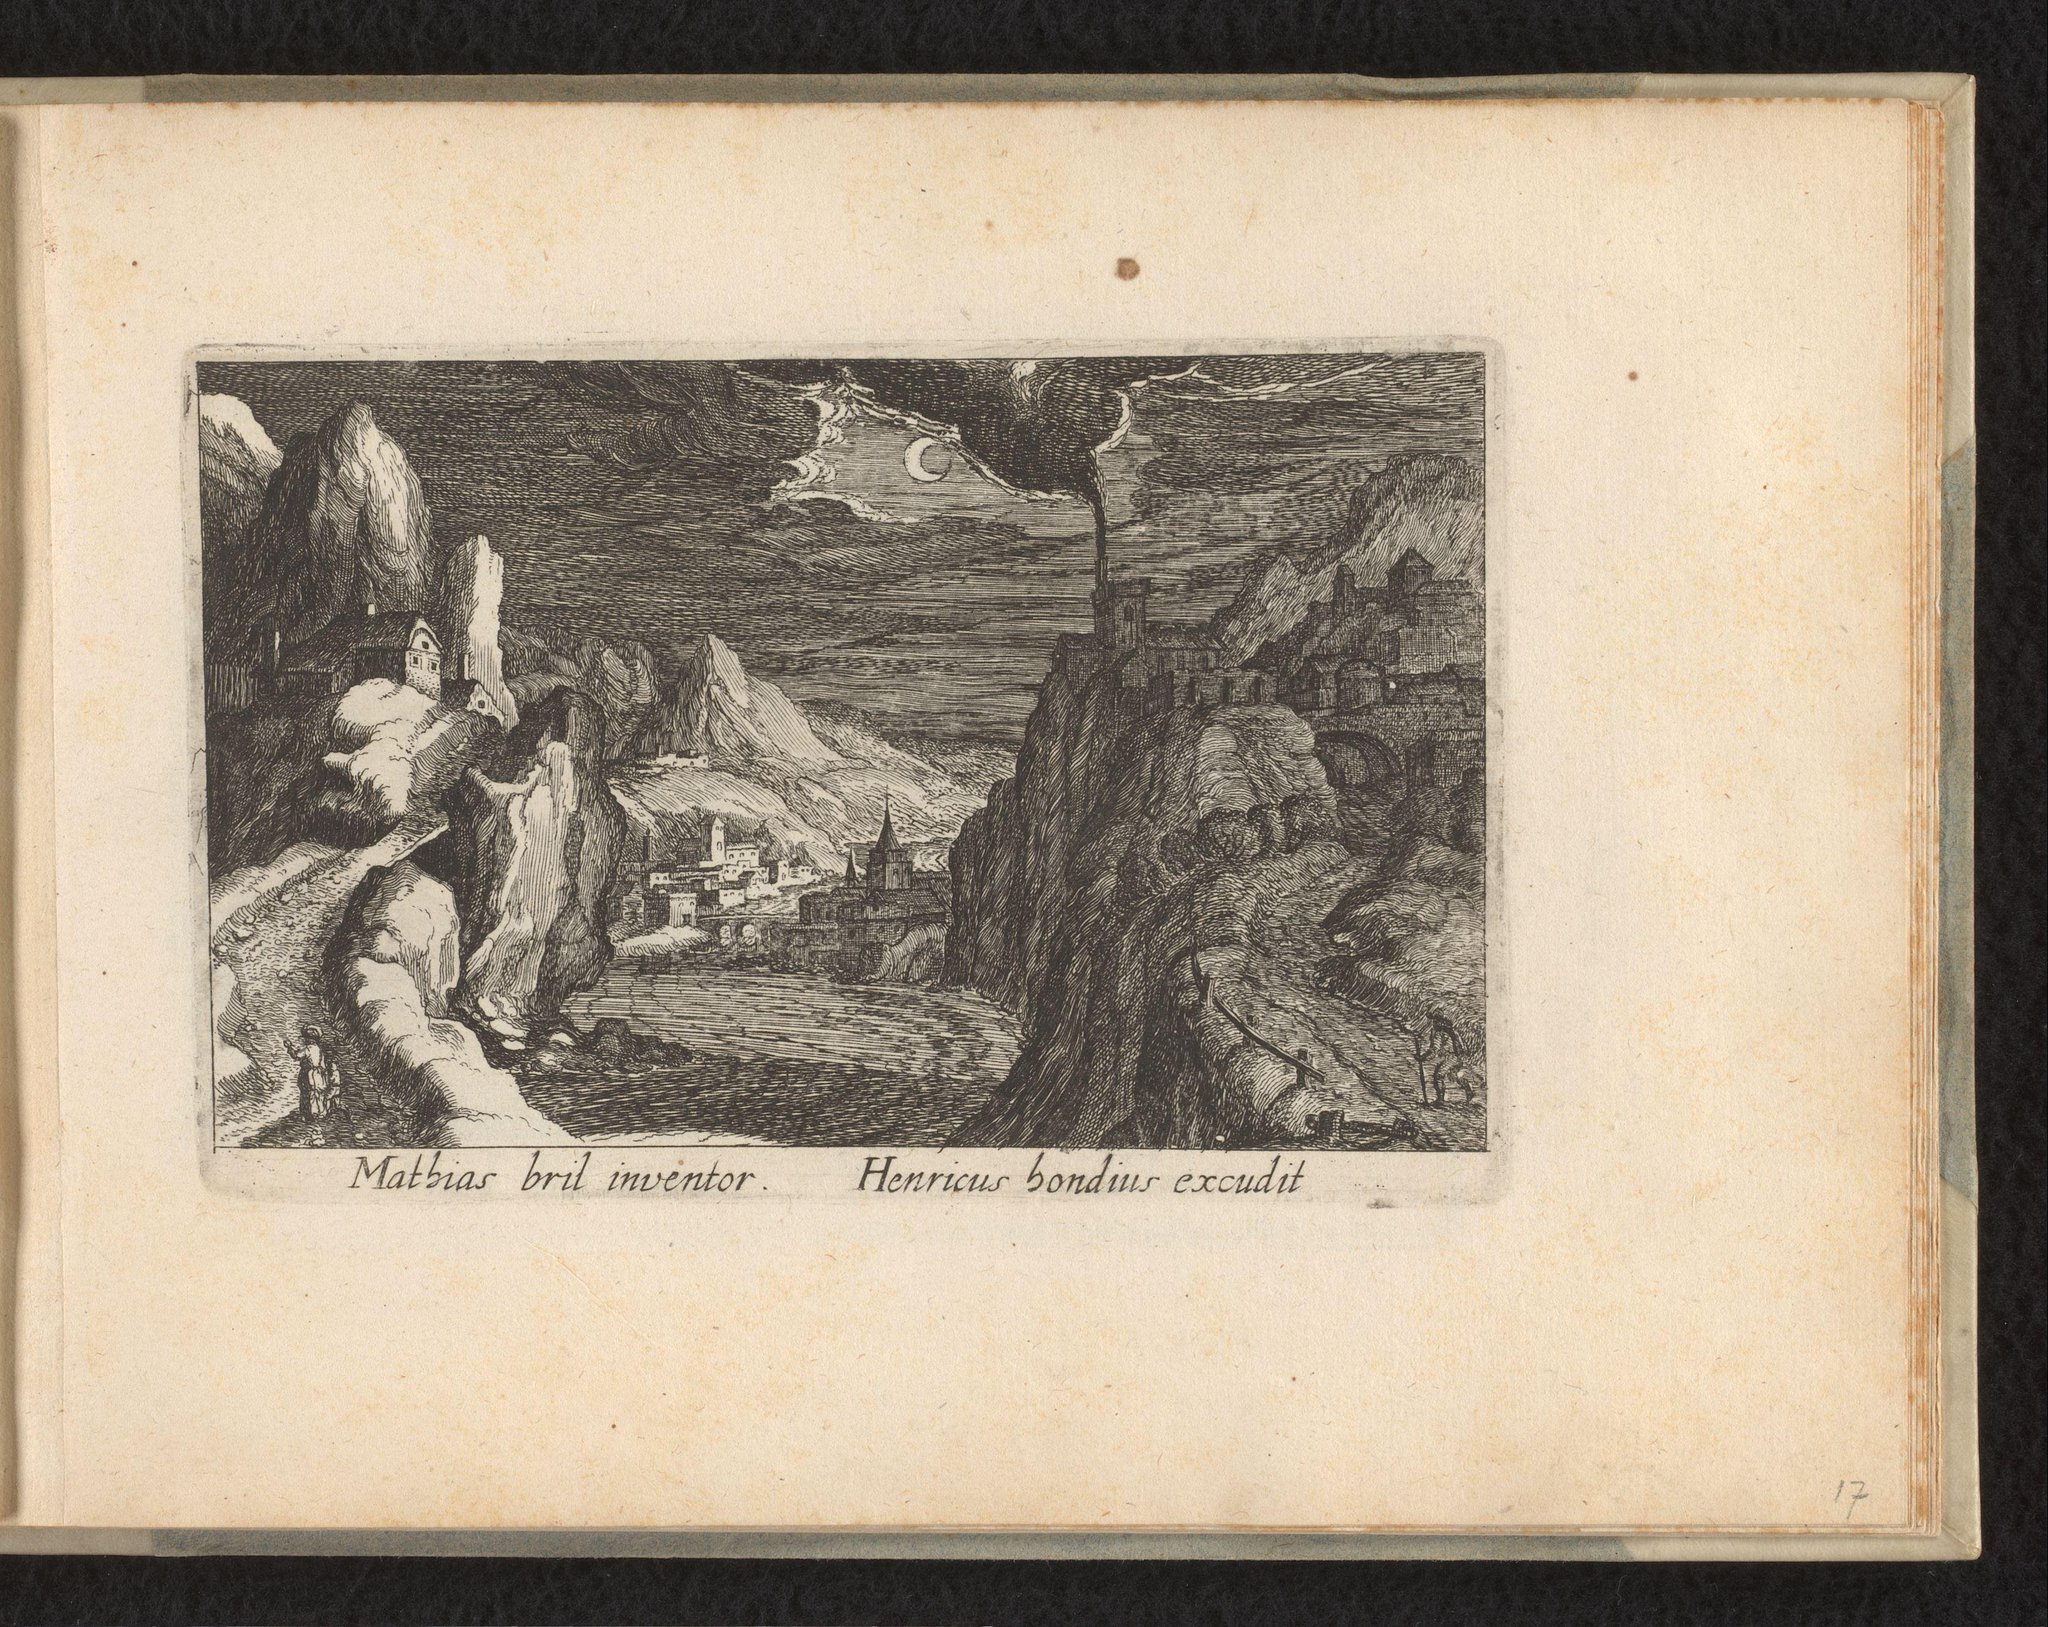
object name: print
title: Heuvellandschap met rivier bij nacht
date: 1614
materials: paper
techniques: etching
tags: village, road, path, night ~ landscape (sometimes titled 'nox')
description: Nachtlandschap. In het midden stroomt een rivier langs een dorp. Links en rechts hoge heuvels met huizen. Op de voorgrond lopende figuren. De maan is zichtbaar achter de wolken.